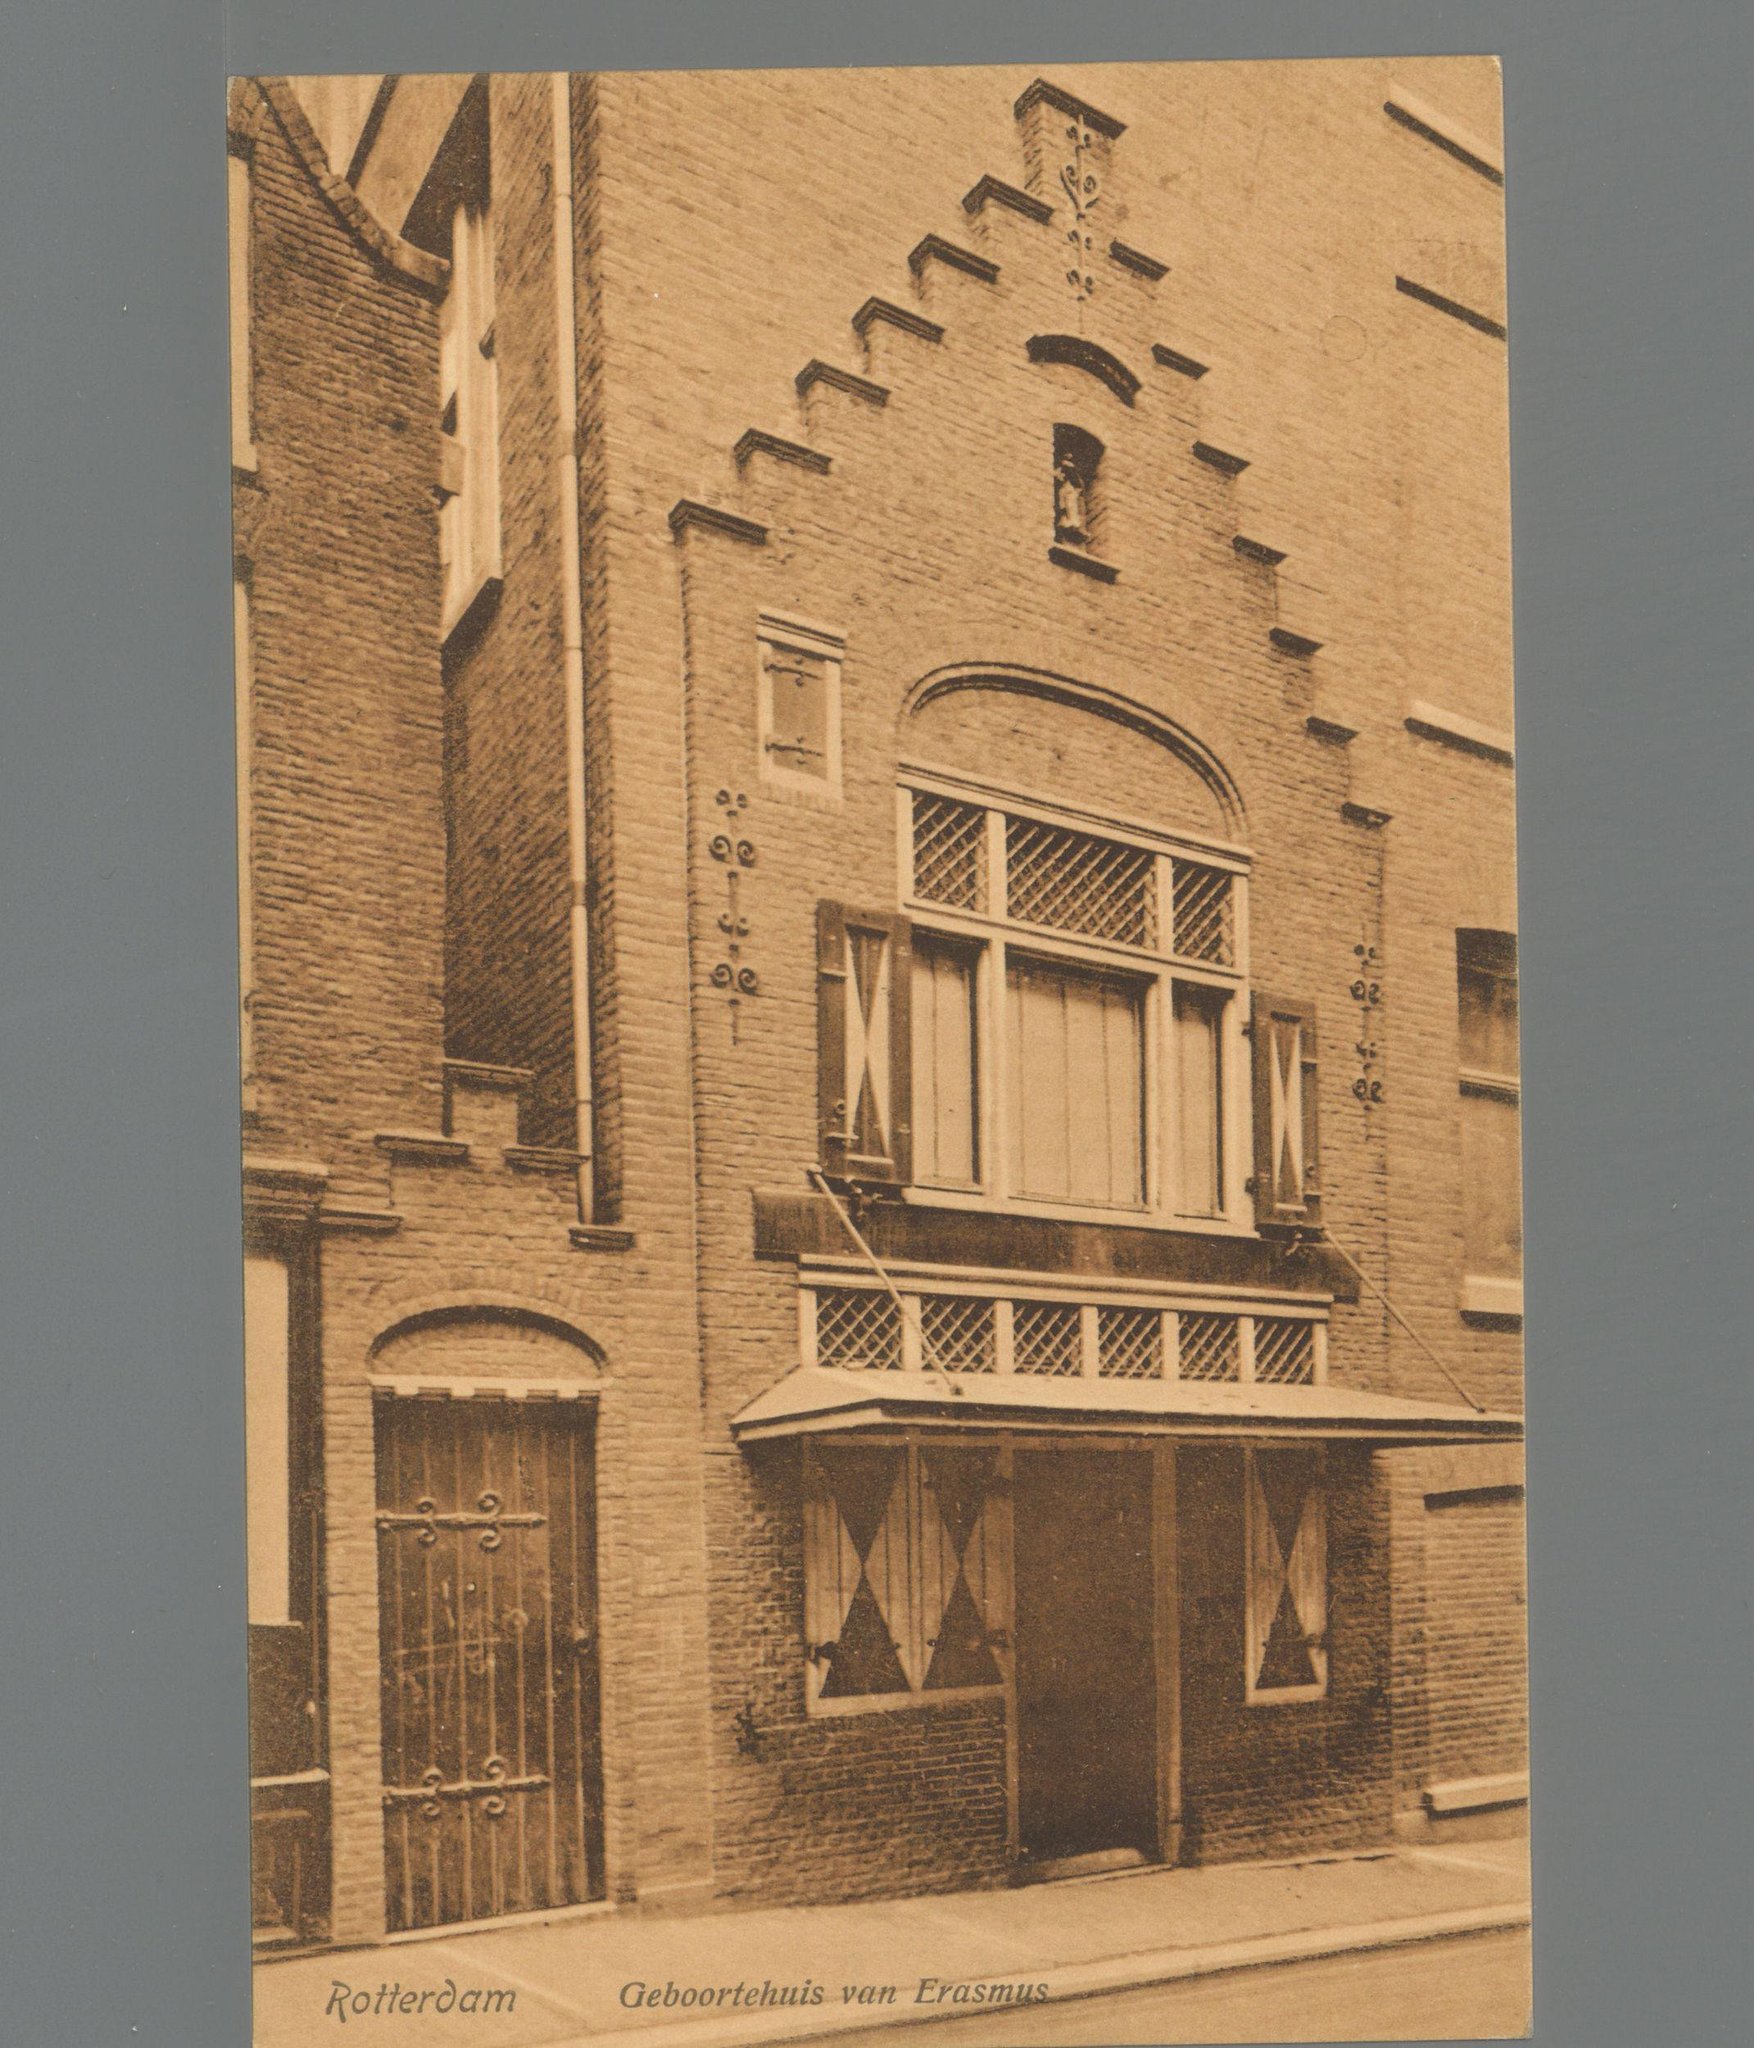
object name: ansichtkaart, prentbriefkaart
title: Rotterdam. Geboortehuis van Erasmus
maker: Anonymous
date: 1911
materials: cardboard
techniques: photograph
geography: leipzig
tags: façade (of house or building), rotterdam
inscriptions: stamp: ‘A.K.O.’